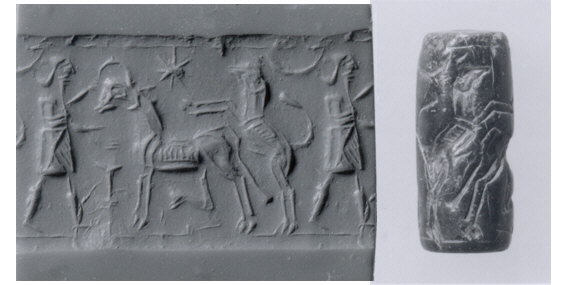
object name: cylinder seal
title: Cylinder seal with animal husbandry scene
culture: assyrian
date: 900-701 BCE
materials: stone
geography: mesopotamia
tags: animals